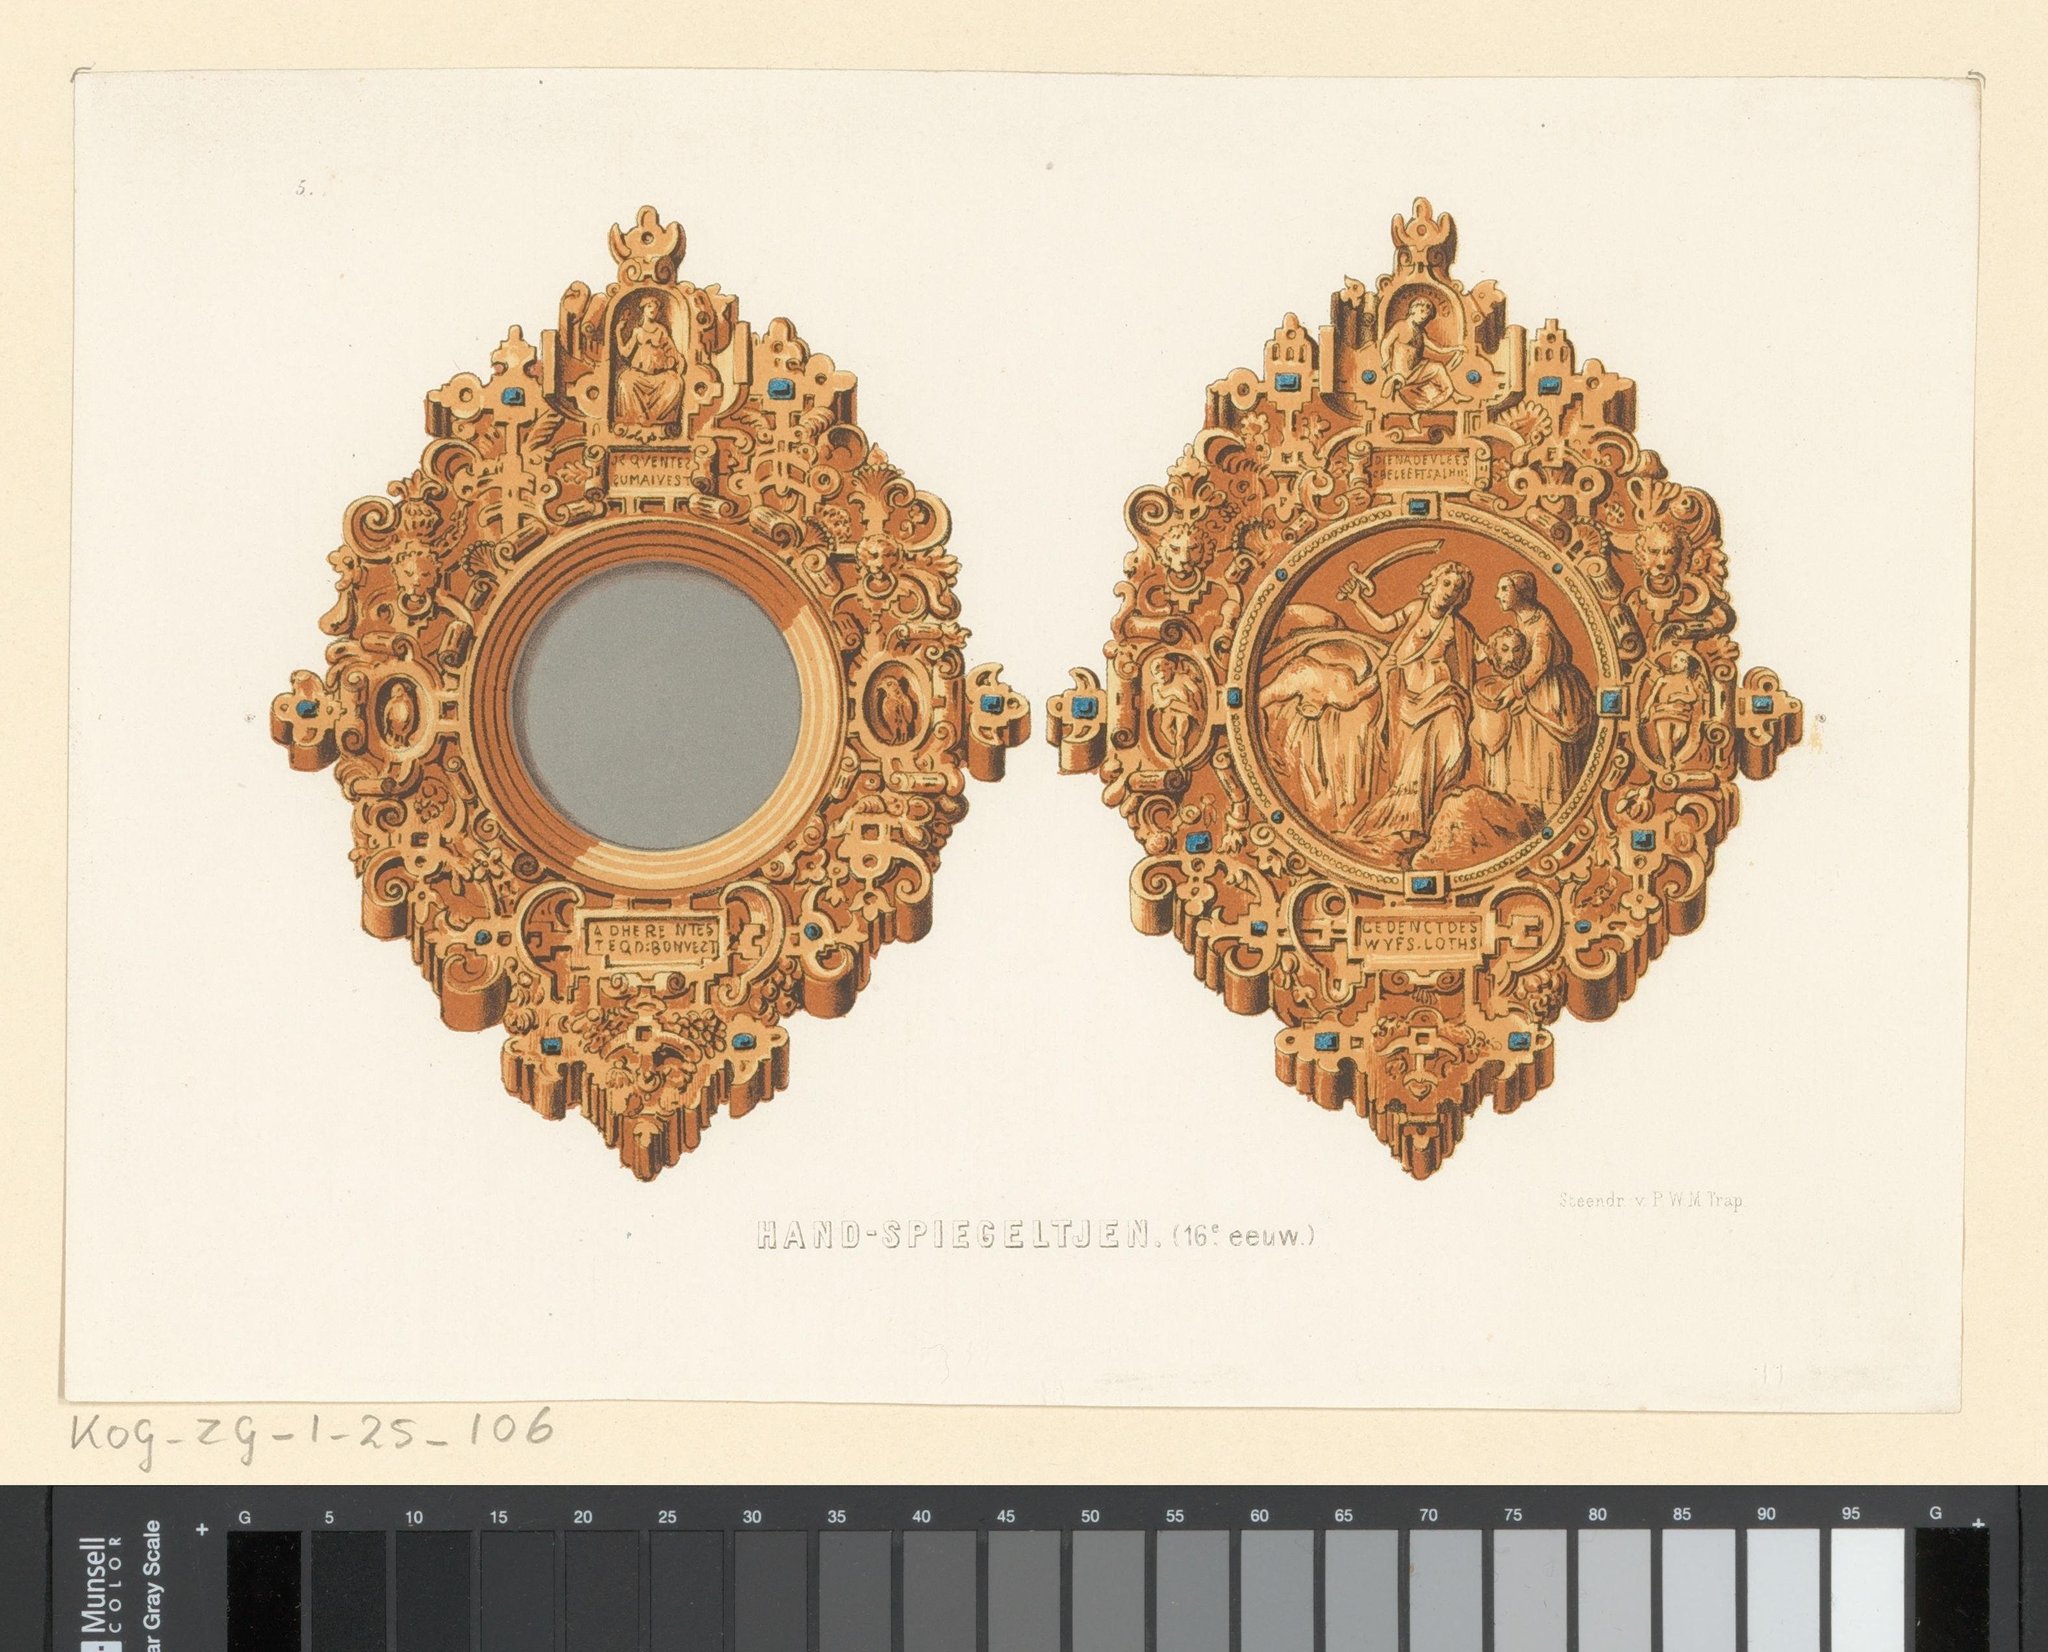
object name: print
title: Handspiegel uit de zestiende eeuw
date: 1875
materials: paper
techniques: tone lithography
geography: leiden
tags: clock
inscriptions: stamp, collector's mark: Lugt 1641, stamp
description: Prent waarschijnlijk uit: Hofdijk, W.J. Ons voorgeslacht in zijn dagelyksch leven geschilderd. Tweede druk. Leiden: P. van Santen, ca. 1875.